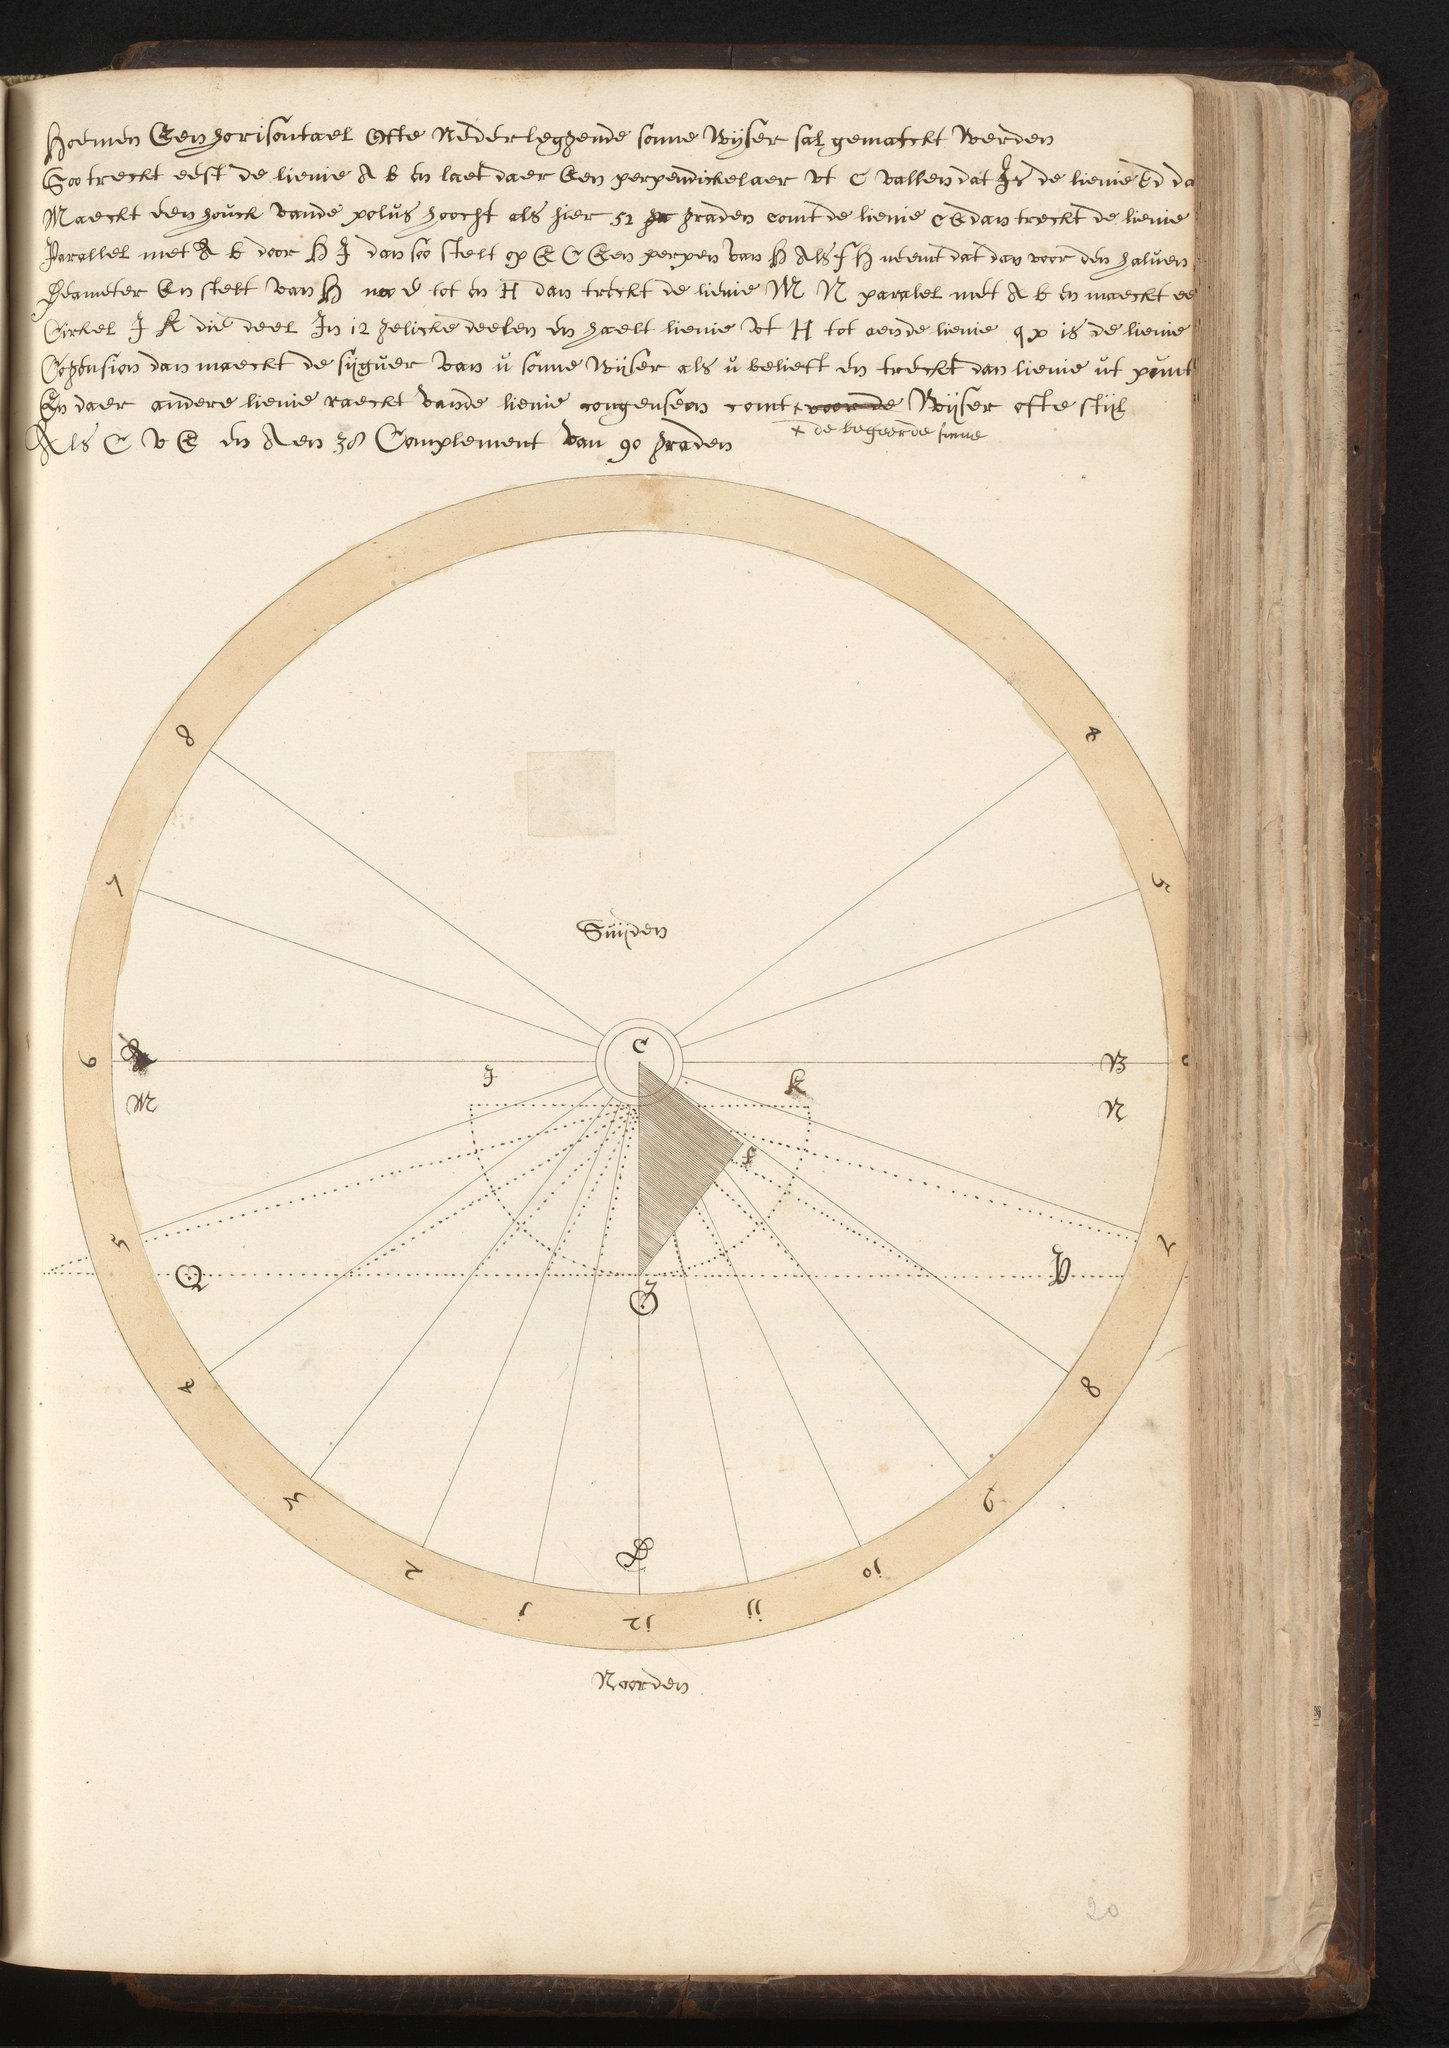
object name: drawing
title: Ontwerp voor een horizontale zonnewijzer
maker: Anonymous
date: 1650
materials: ink, paper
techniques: brush, pen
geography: low countries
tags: sundial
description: Met berekeningen. Tekening maakt deel uit van een album.